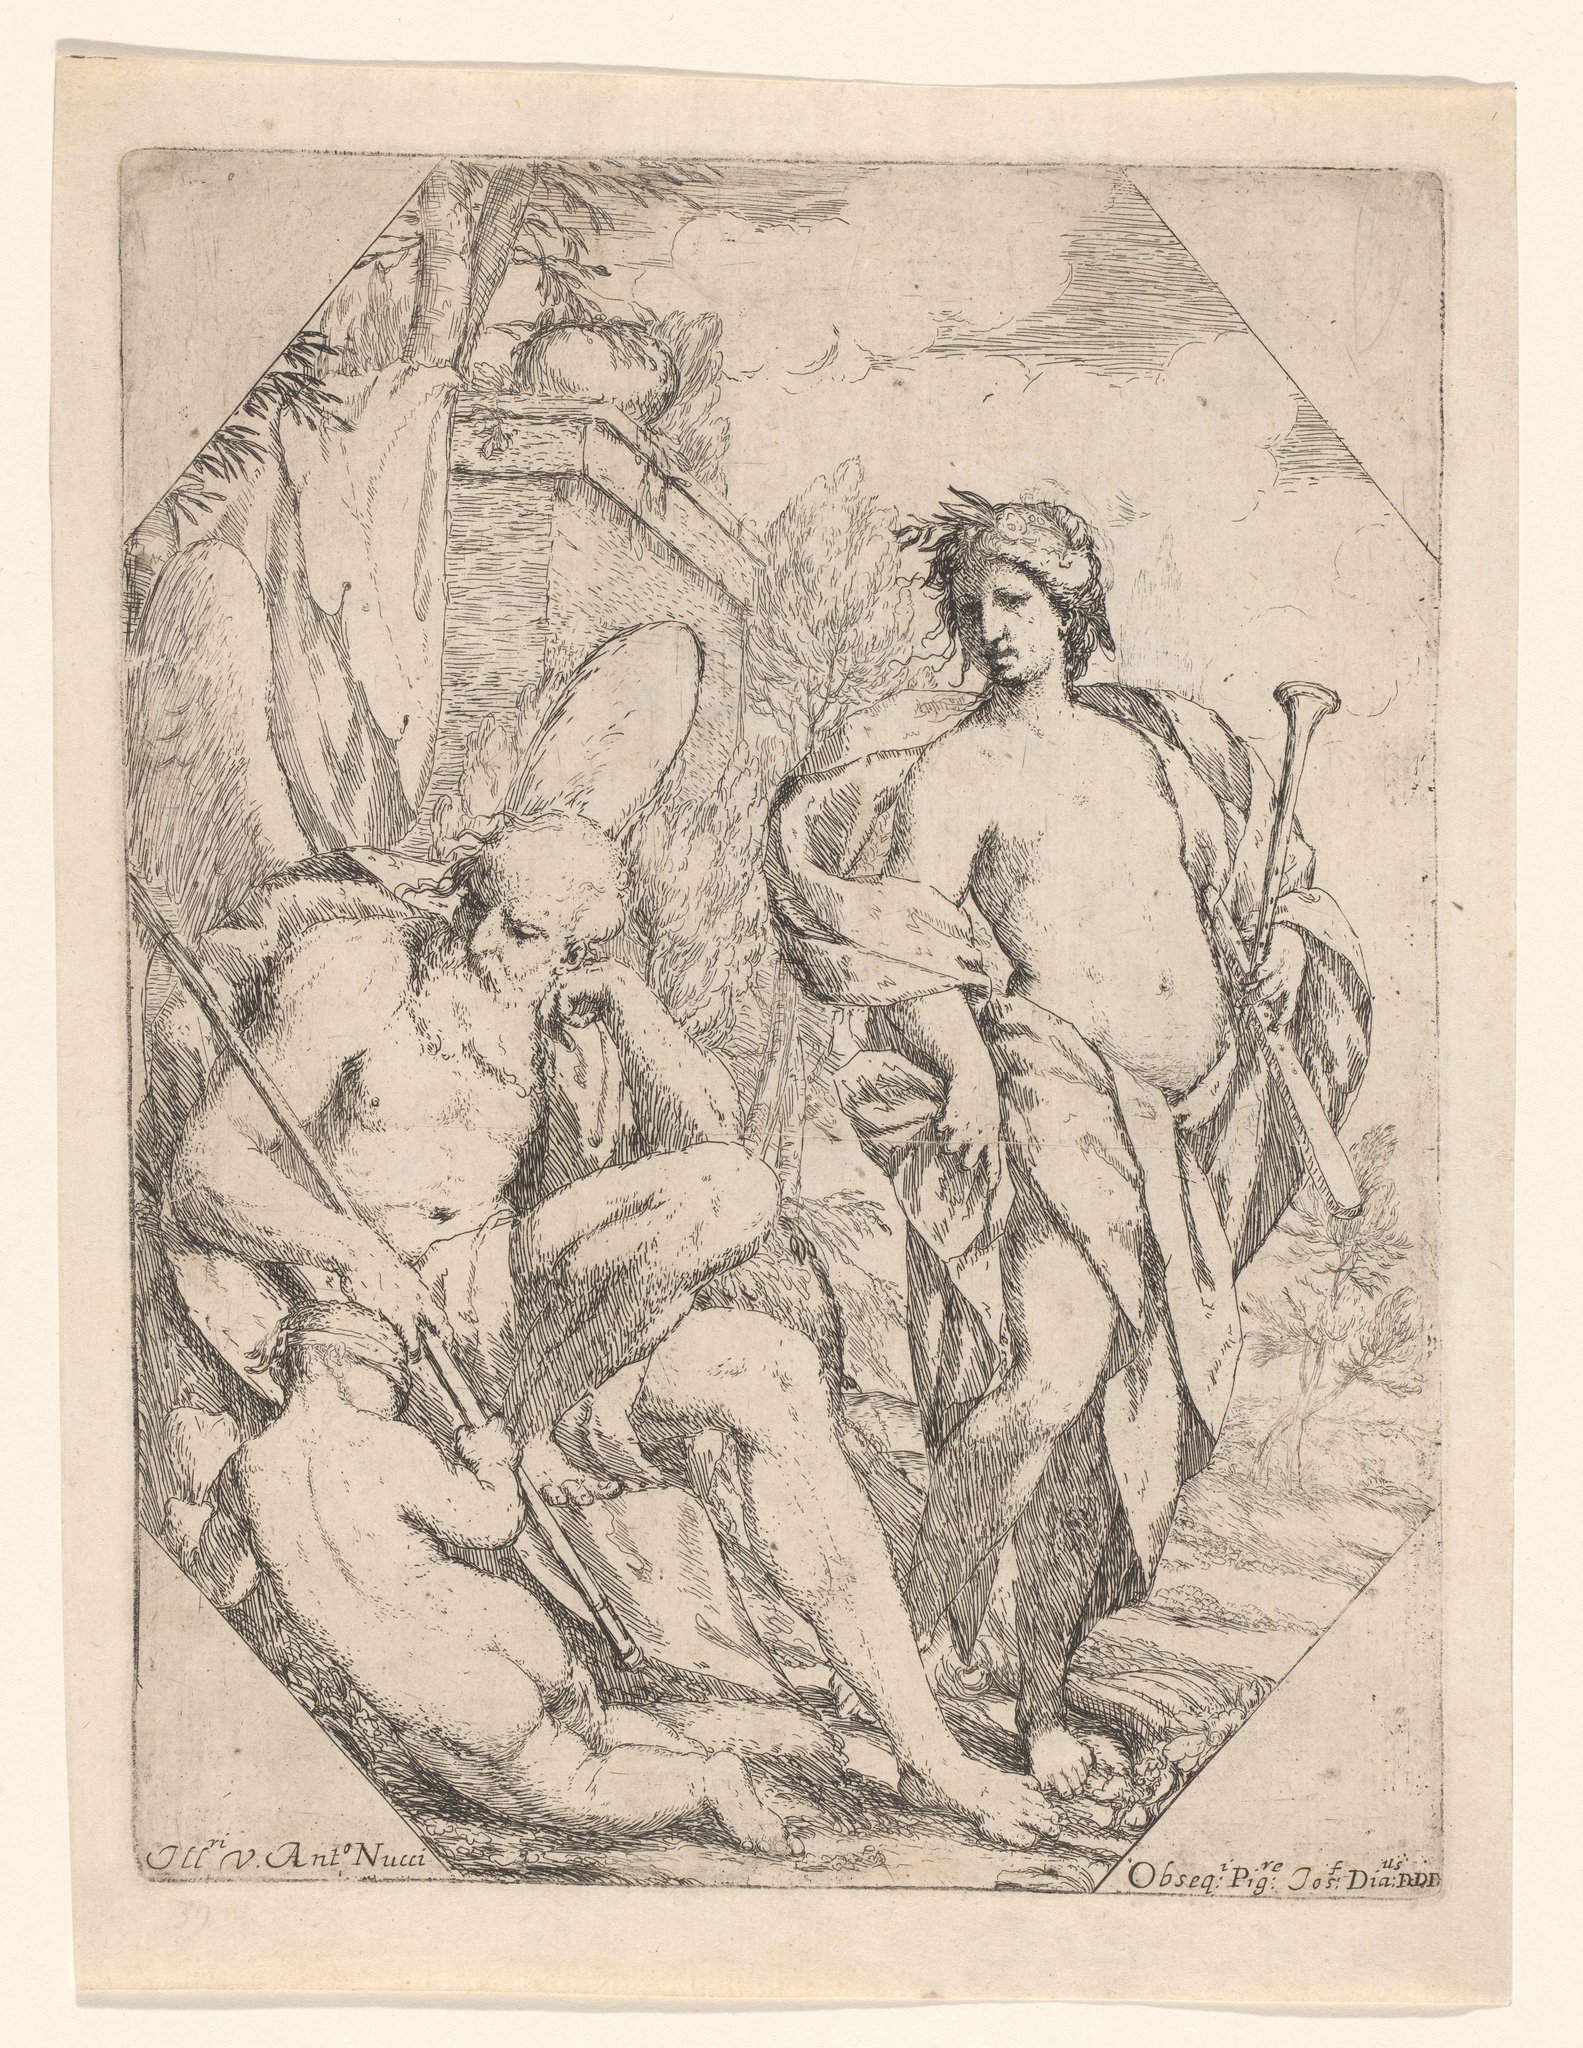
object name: print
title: Allegorie met Saturnus, Eros en de Roem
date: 1660-1680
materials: paper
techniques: etching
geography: venice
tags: (story of) saturn (cronus), (story of) cupid, amor (eros), fame; 'fama', 'fama buona', 'fama chiara' (ripa)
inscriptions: collector's mark: Lugt 2228